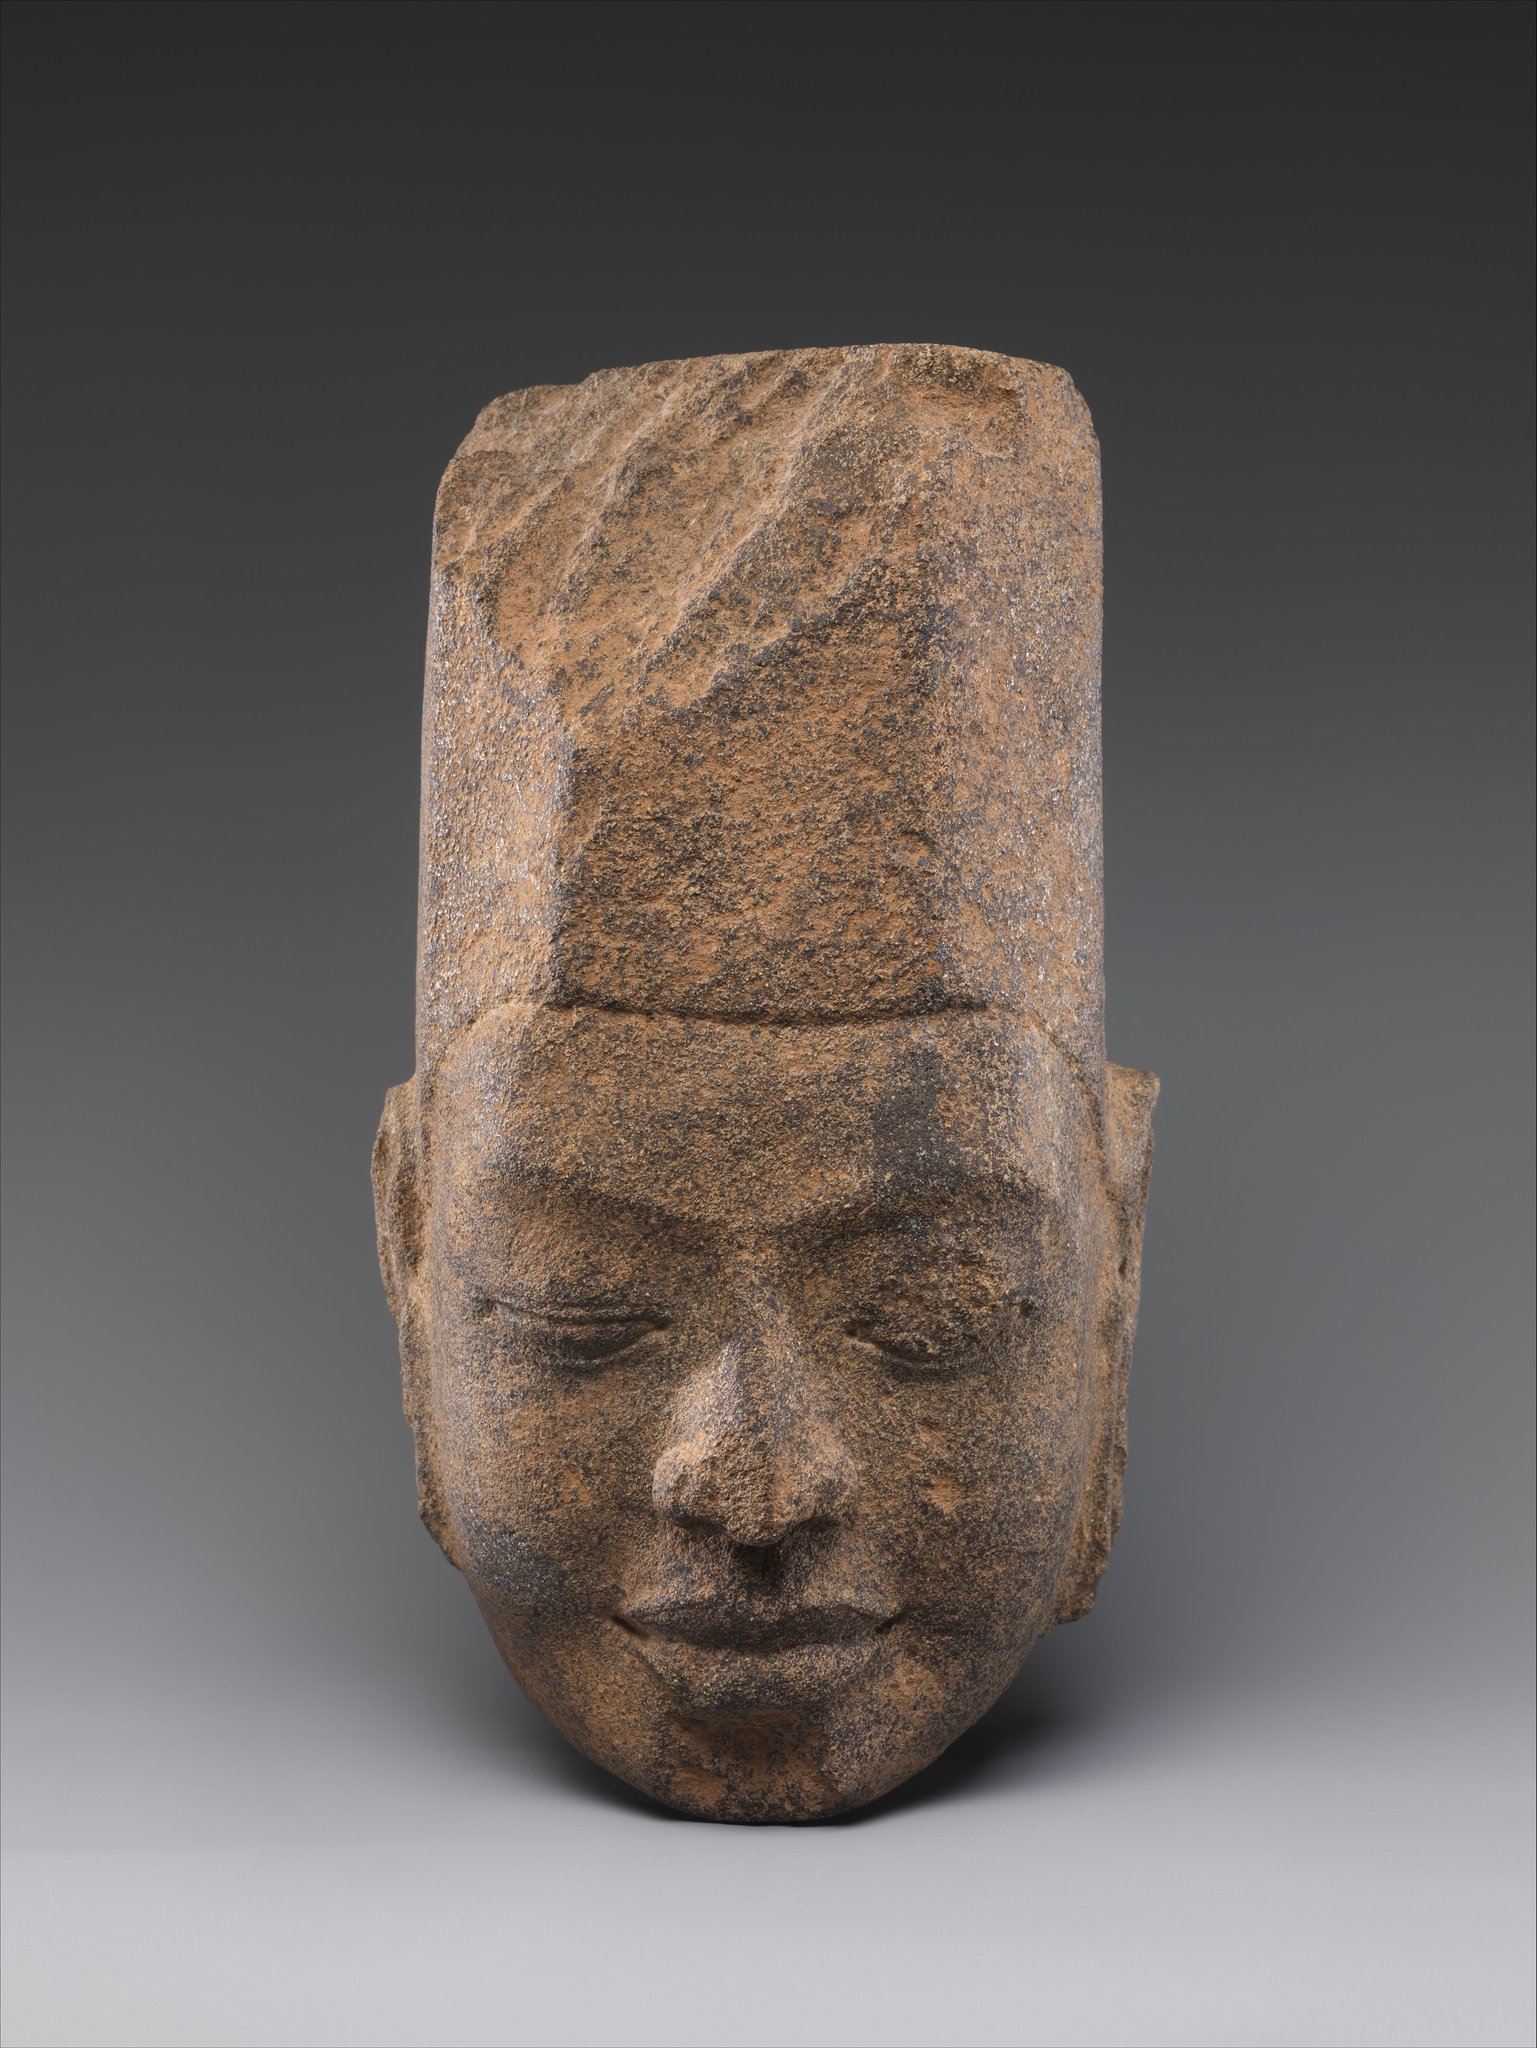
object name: head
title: Head of Krishna (?)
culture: thai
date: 601-700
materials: stone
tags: heads,krishna,hinduism